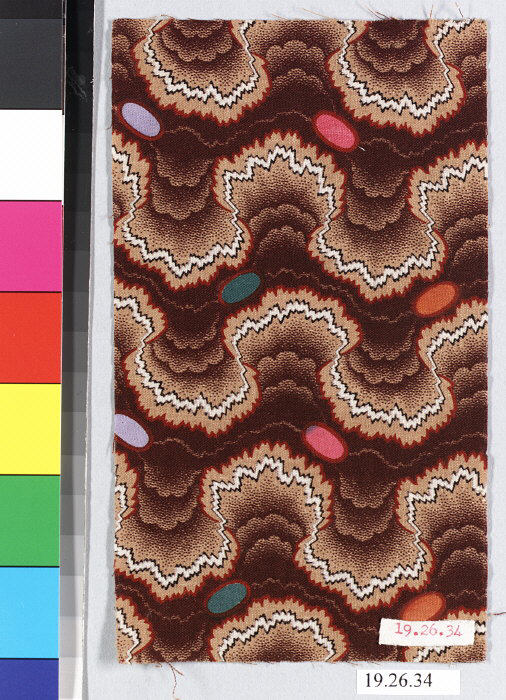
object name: sample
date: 1840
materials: cotton